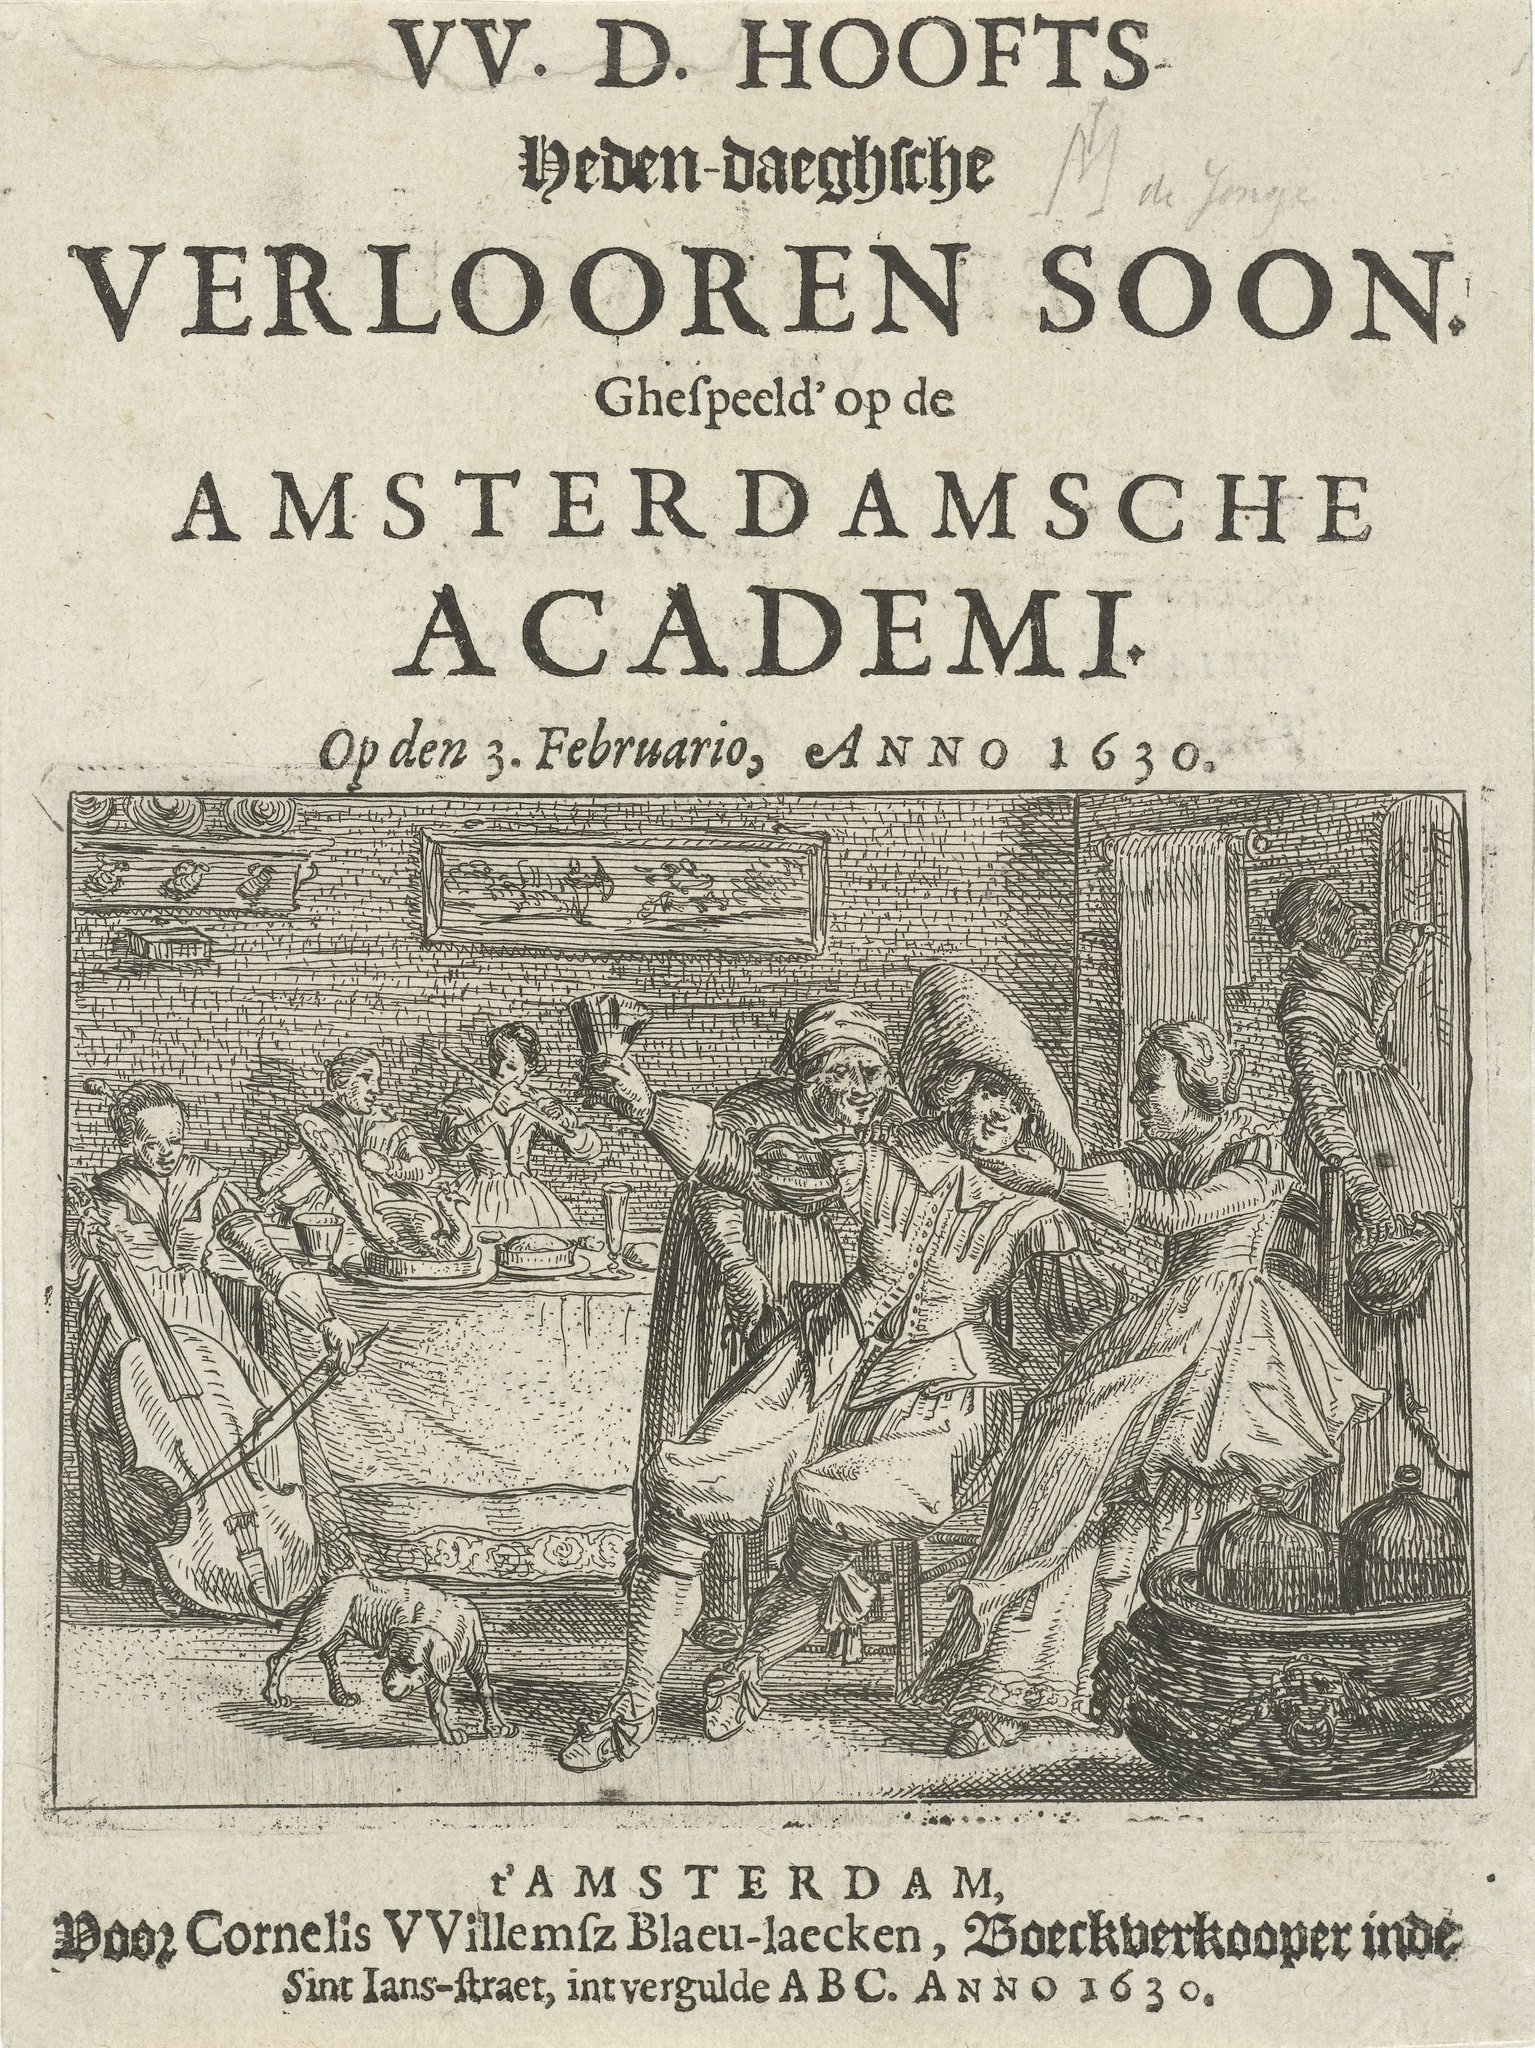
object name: titelblad, titelpagina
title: Titelpagina voor: W.D. Hooft, Hedendaagse verloren zoon, 1630.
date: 1630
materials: paper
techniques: etching, letterpress printing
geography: amsterdam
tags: brothel, the prodigal son in the midst of prostitutes feasting and dissipating his patrimony, usually in a brothel or inn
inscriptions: date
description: Titelpagina met de scene van de verloren zoon, gekleed in 17e eeuws kostuum, die zijn geld verbrast met lichtekooien. Hij zit in een interieur met musicerende en drinkende vrouwen, terwijl een koppelaarster hem zijn beurs afhandig maakt.